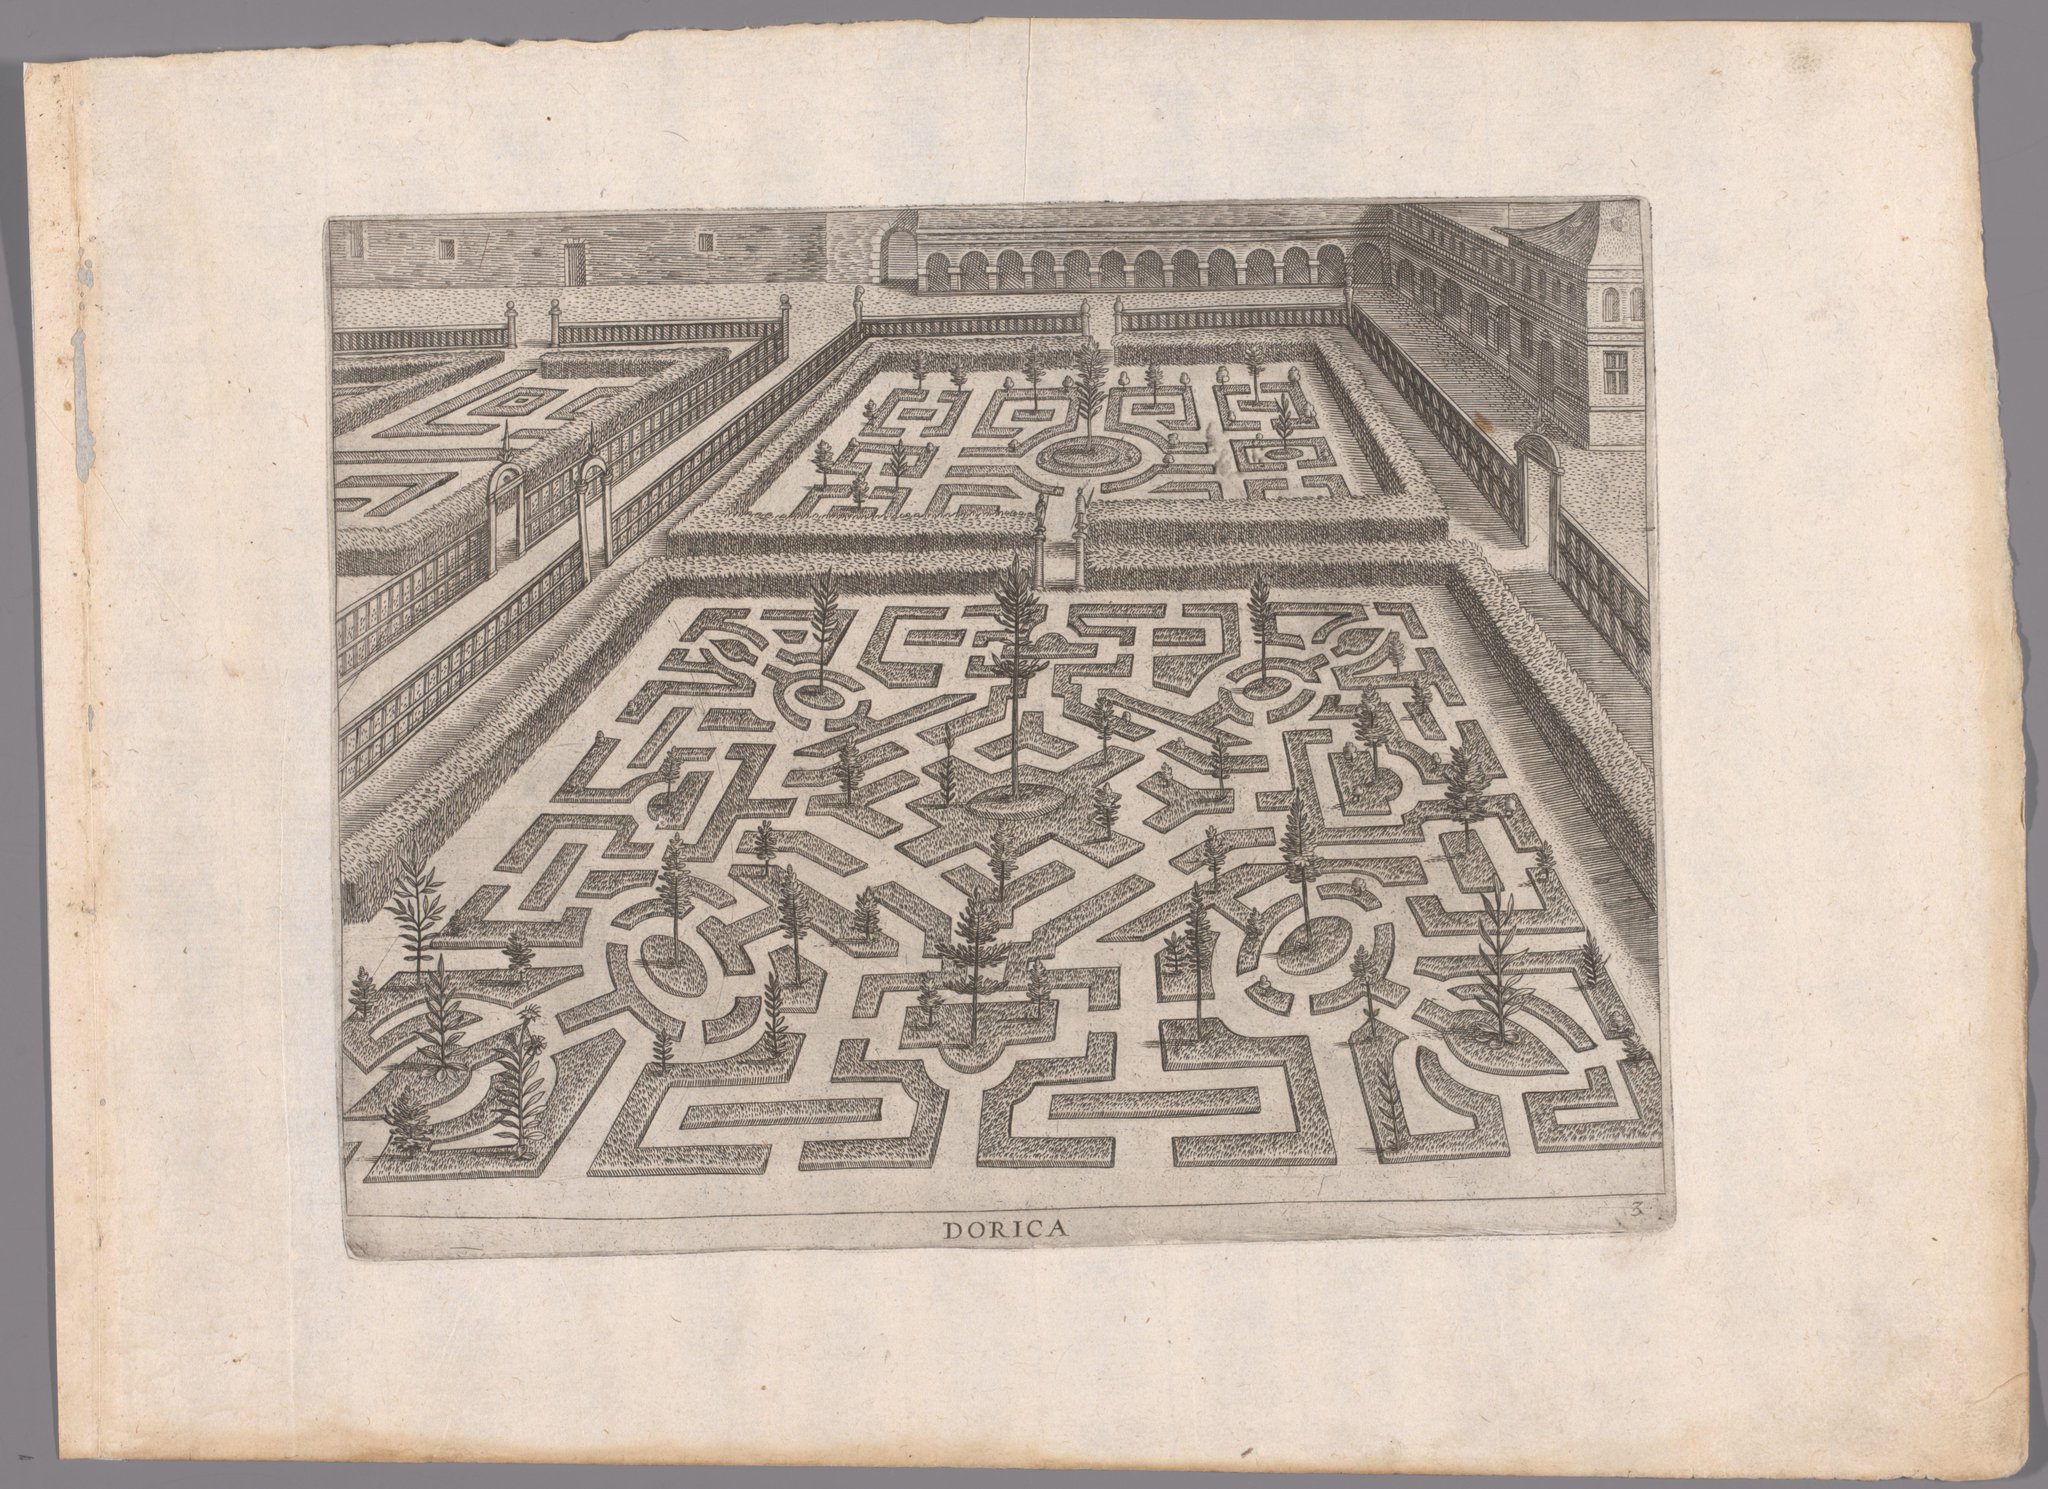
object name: ornament print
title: Dorica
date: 1583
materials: paper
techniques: etching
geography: antwerp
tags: garden, french or architectonic garden; formal garden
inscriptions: collector's mark: Lugt 2228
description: Deel van een ontmanteld album waarvan RP-P-2013-1-54-1 t/m -37, RP-P-2013-1-55-1 en -2 en RP-P-2013-1-63 t/m 67 deel waren.